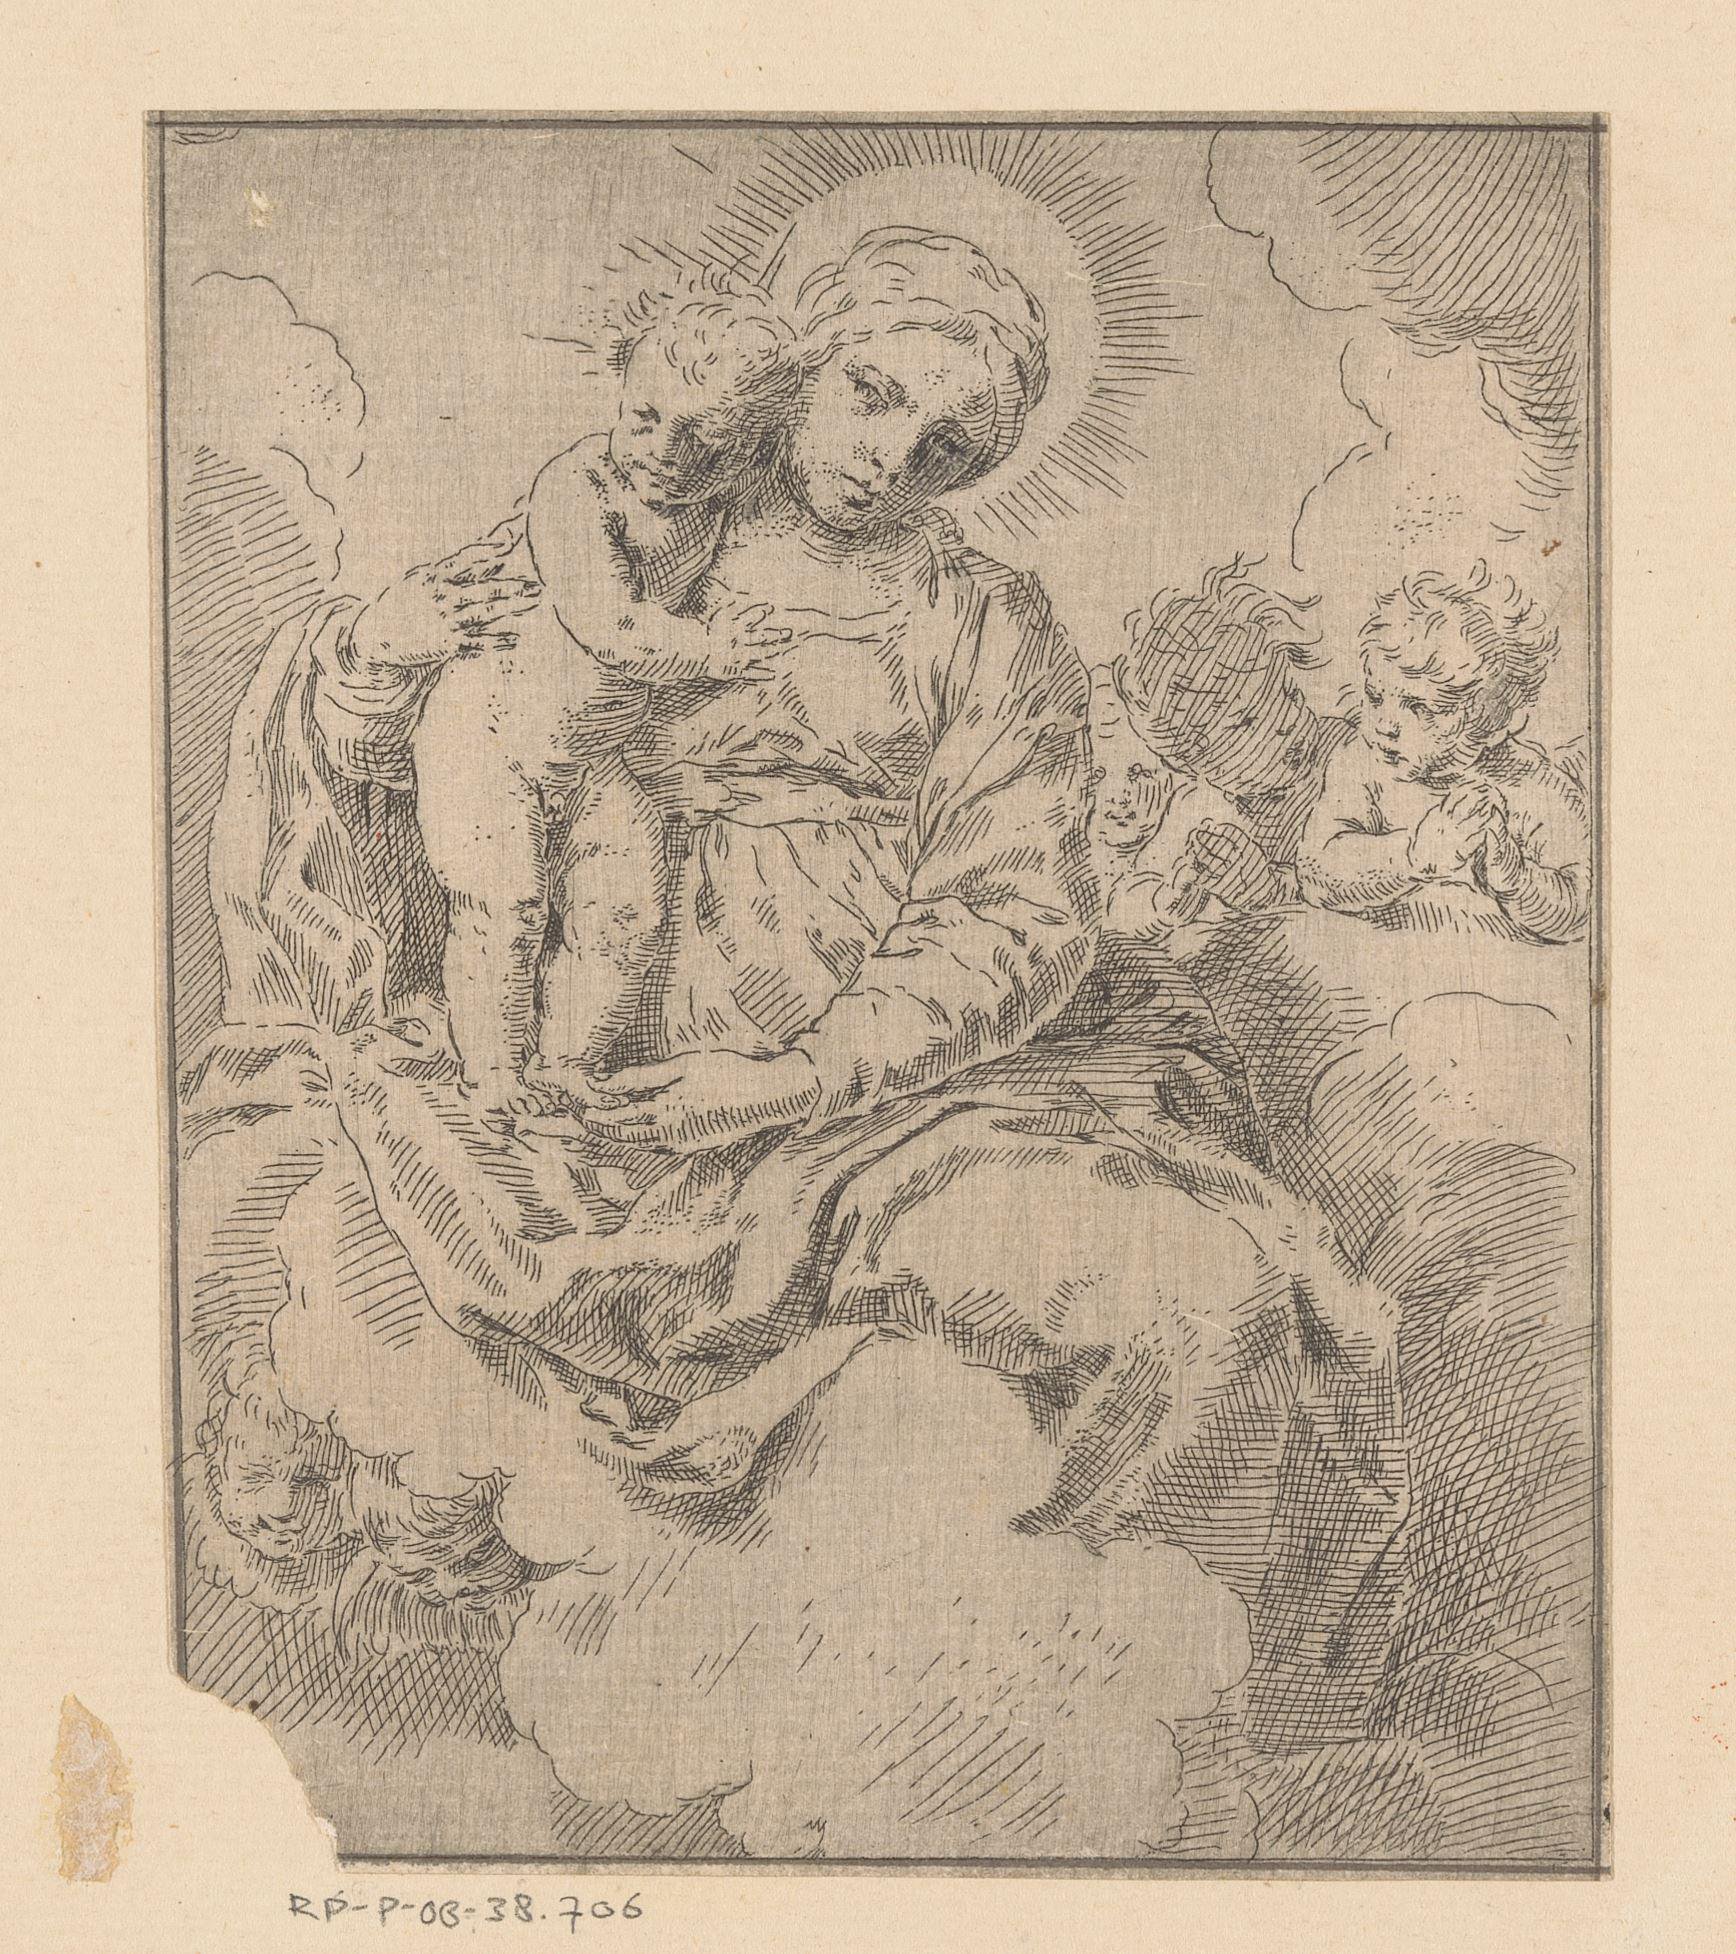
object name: print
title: Maria met Kind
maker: Anonymous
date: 1595-1692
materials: paper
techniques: etching, intaglio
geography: italy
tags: cherubs, i.e. children's heads with wings, madonna (i.e. mary with the christ-child) in the air, or on the clouds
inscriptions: collector's mark: Lugt 240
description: Maria met het Christuskind op een wolkenpartij, omgeven door putti en cherubijnen.